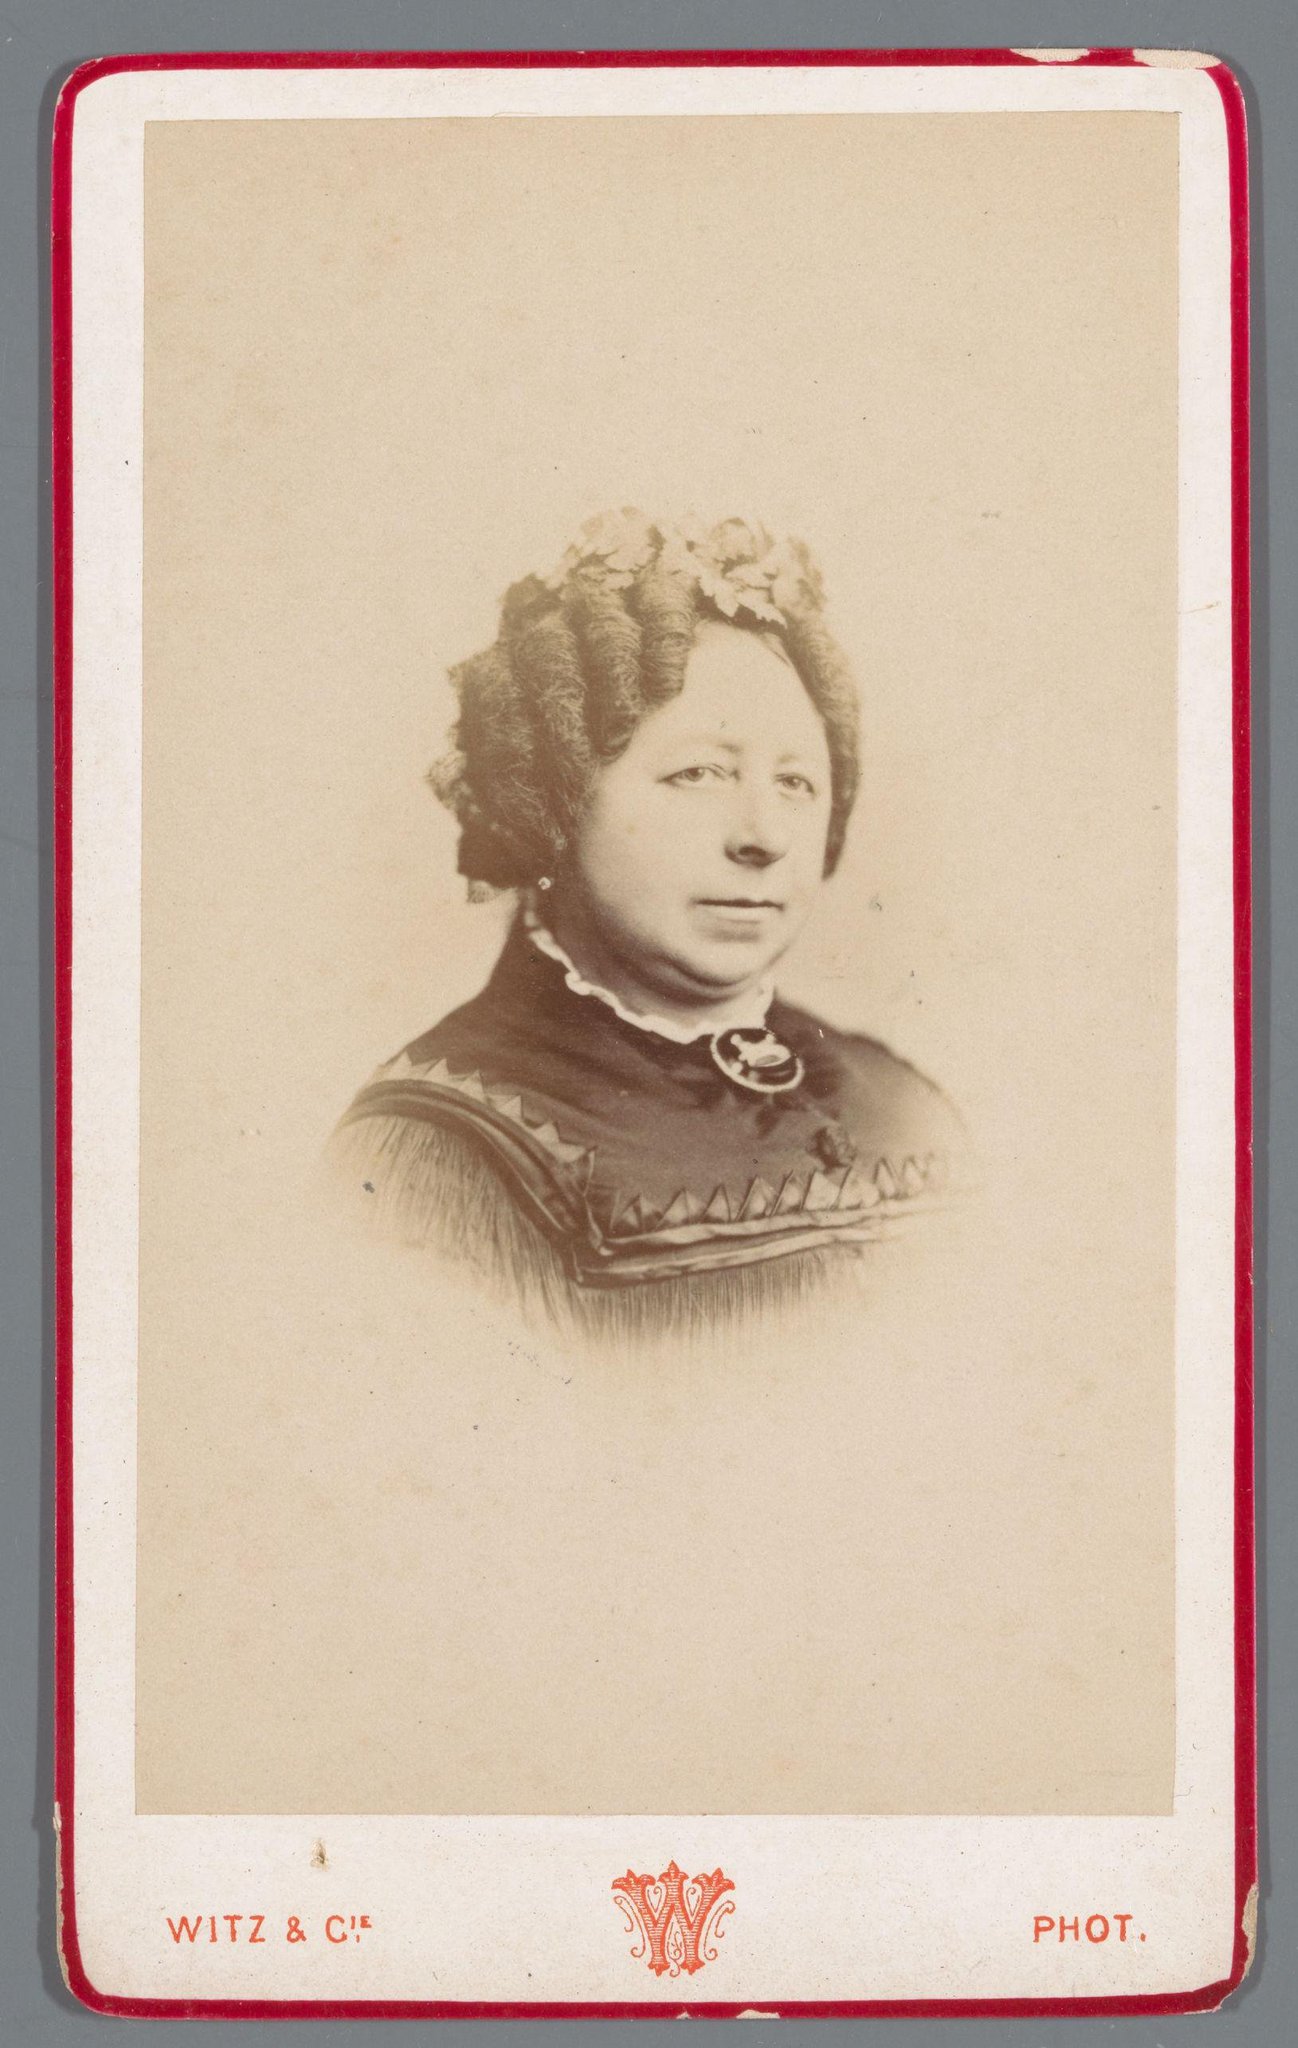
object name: carte de visite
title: Portret van een onbekende vrouw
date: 1855-1885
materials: cardboard, paper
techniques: albumen print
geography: rouen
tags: adult woman, anonymous historical person portrayed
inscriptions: address: ‘46. Place des Carmes, 46/ ROUEN’, number: ‘46300’